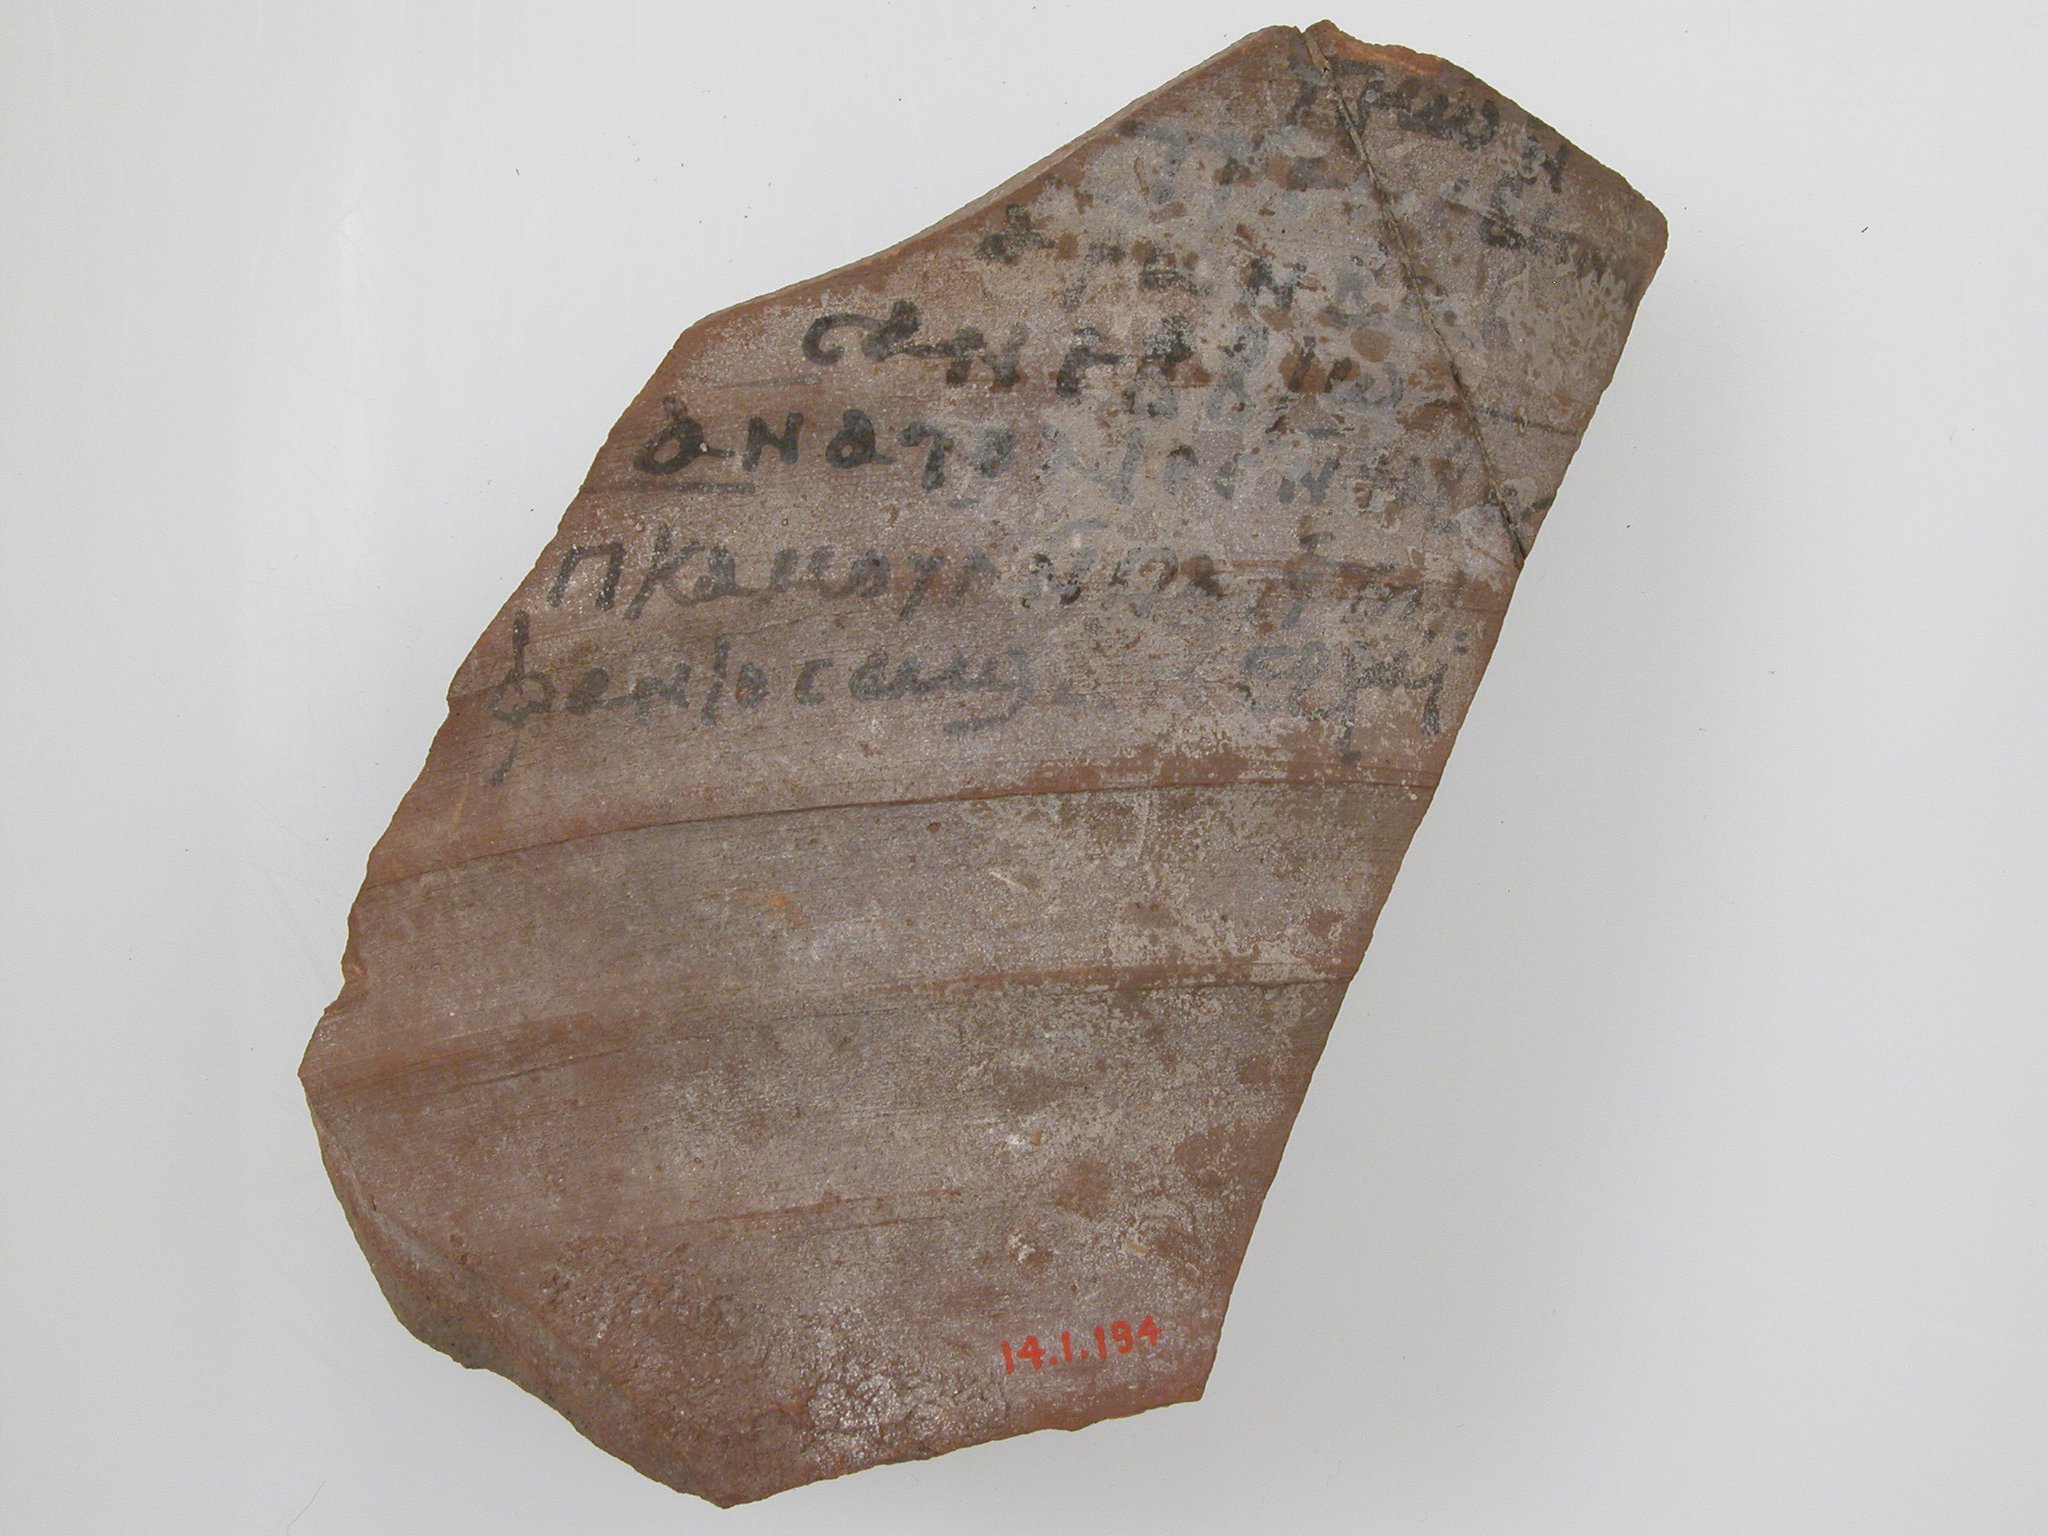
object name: ostrakon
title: Ostrakon with a List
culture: coptic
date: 580-640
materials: ink, pottery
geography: egypt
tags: coptic,documents